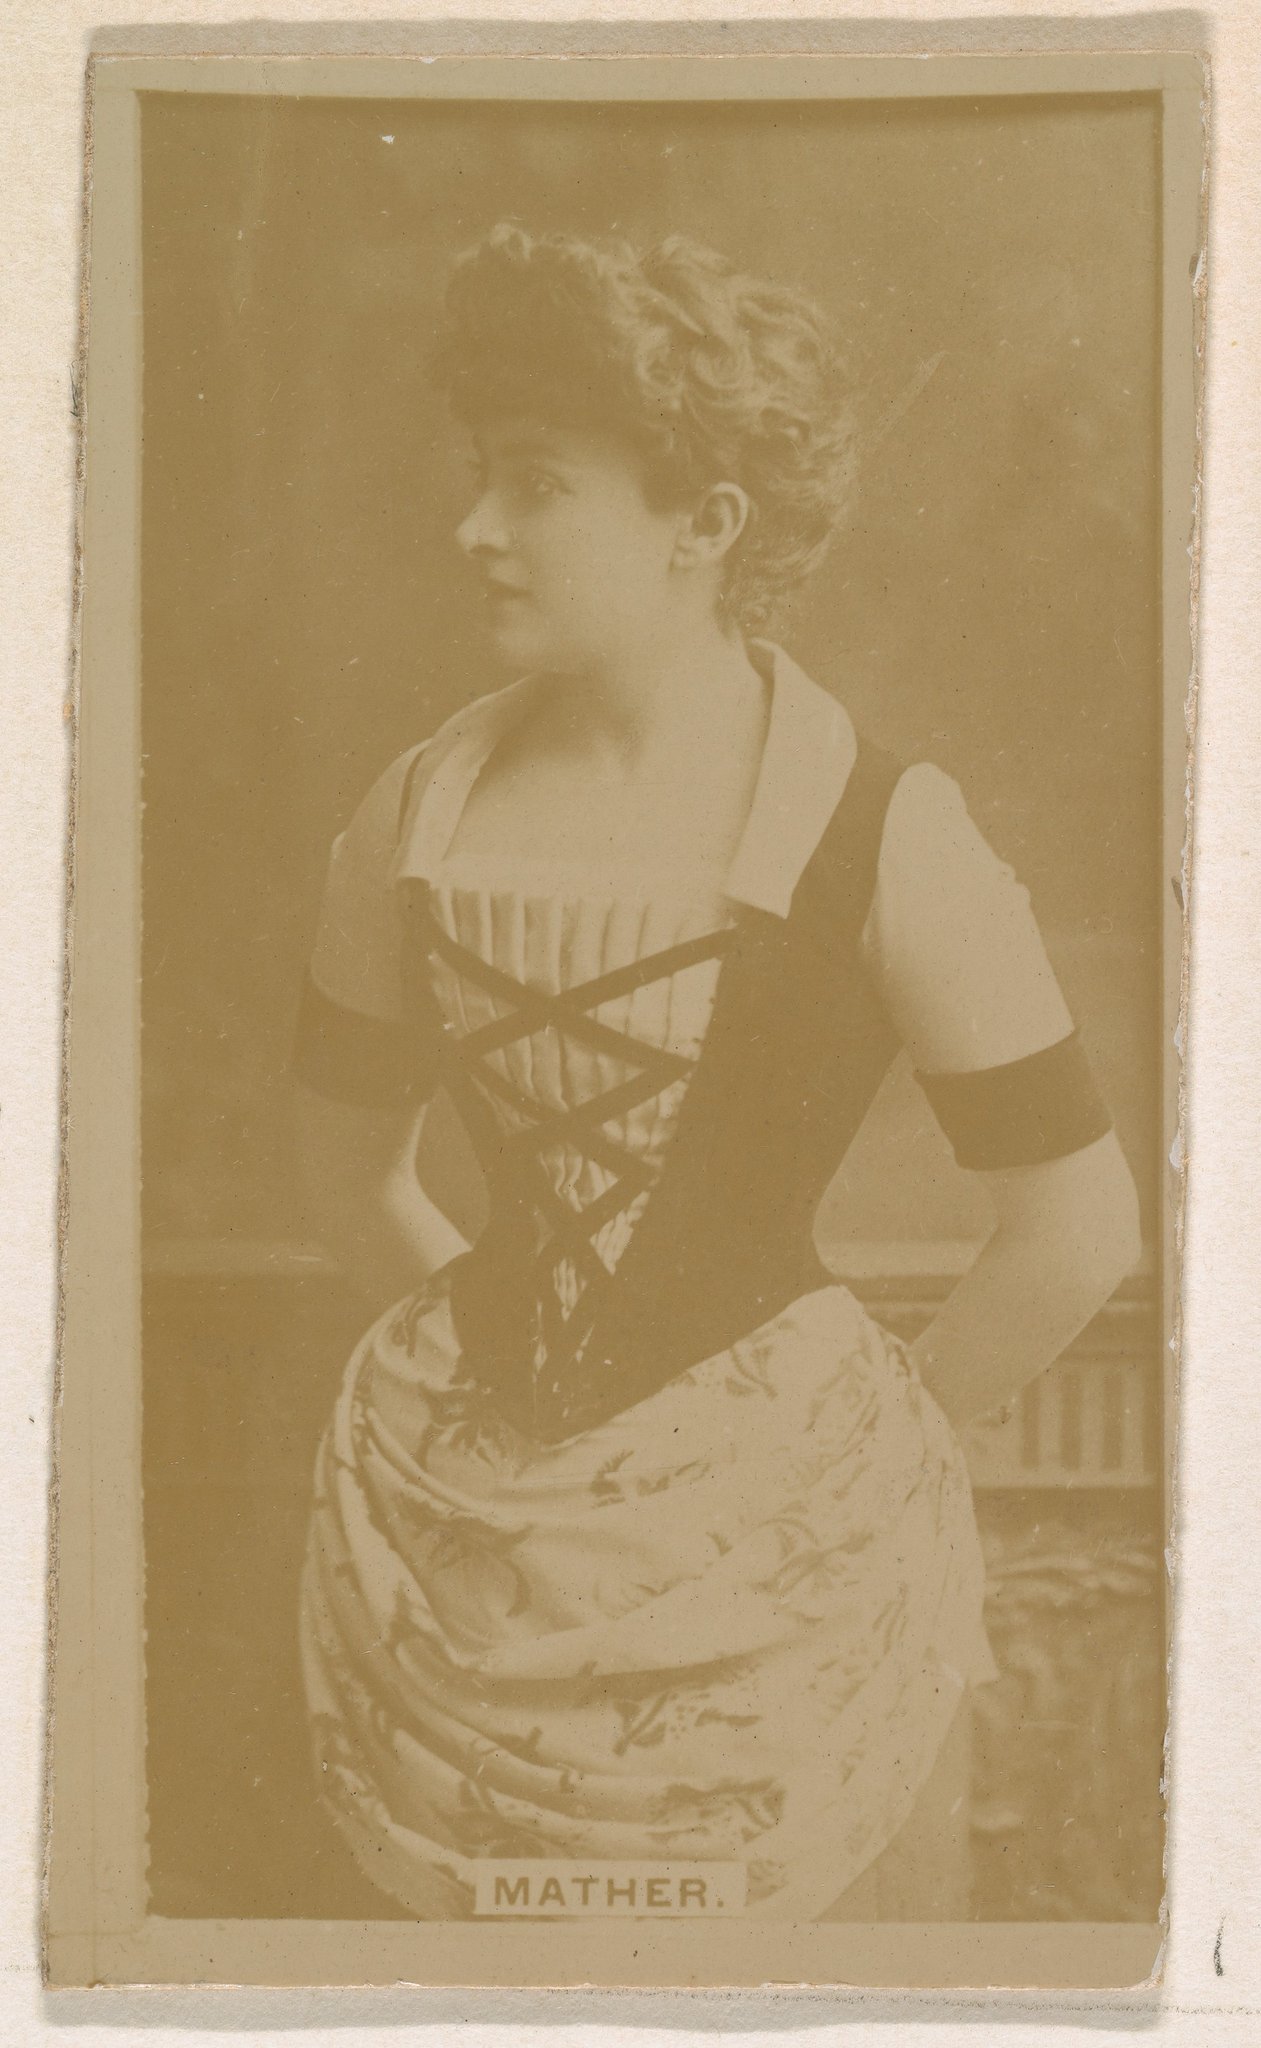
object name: photograph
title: Margaret Mather, from the Actresses series (N245) issued by Kinney Brothers to promote Sweet Caporal Cigarettes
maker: kinney brothers tobacco company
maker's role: publisher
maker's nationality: american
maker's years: 1869-2011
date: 1890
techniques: albumen silver print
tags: portraits,women,actresses